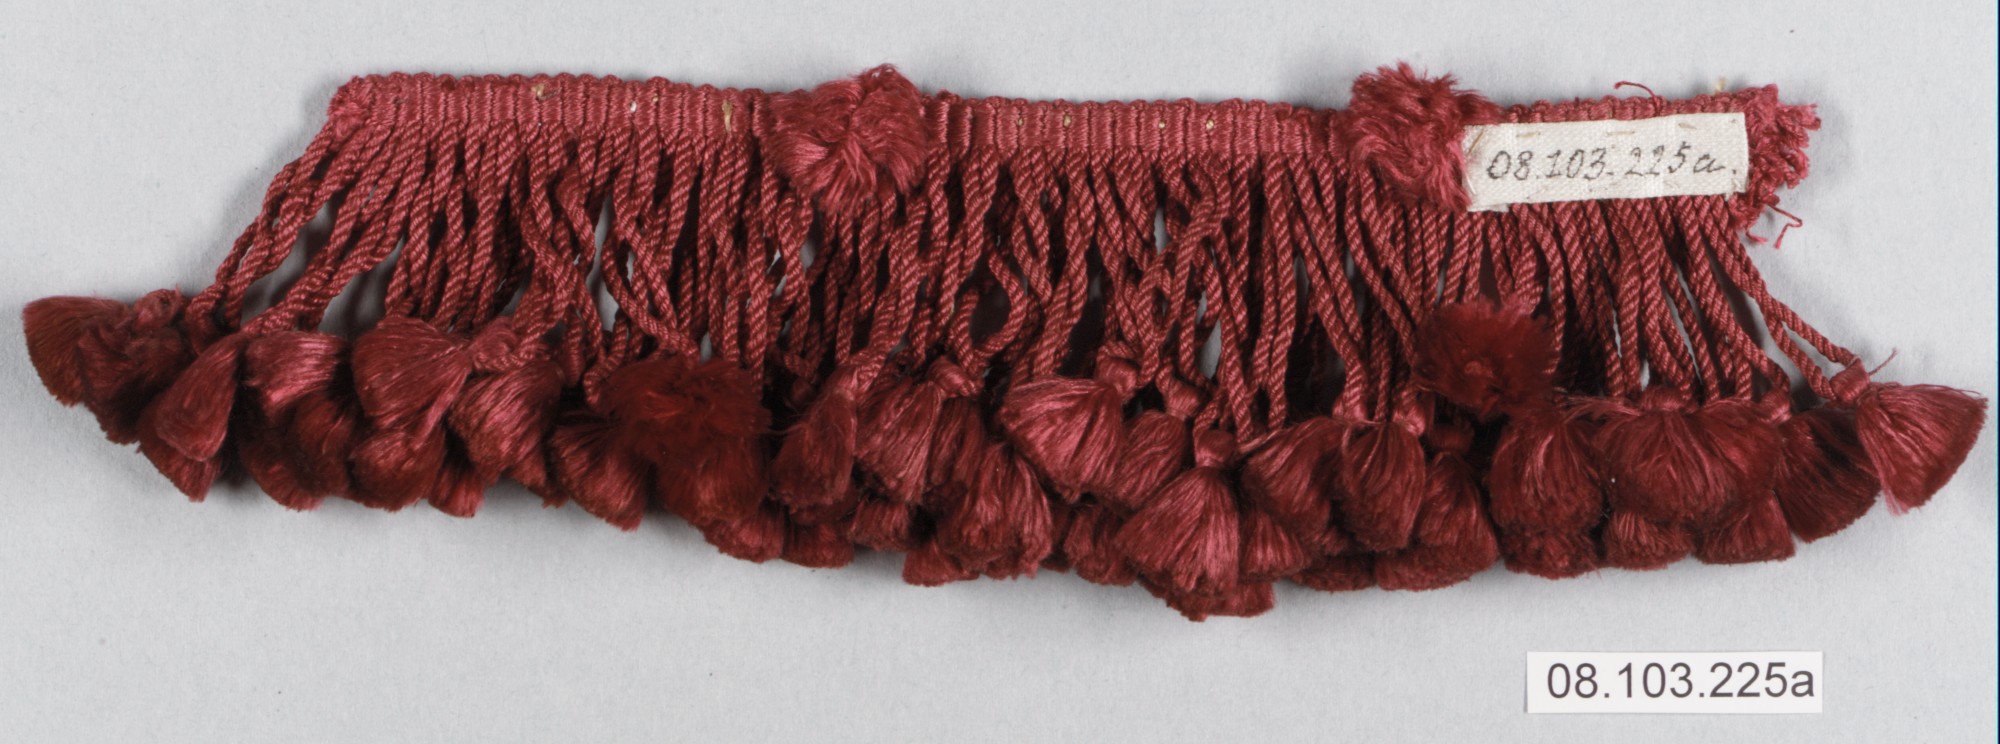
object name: fringe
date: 1701-1800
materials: silk